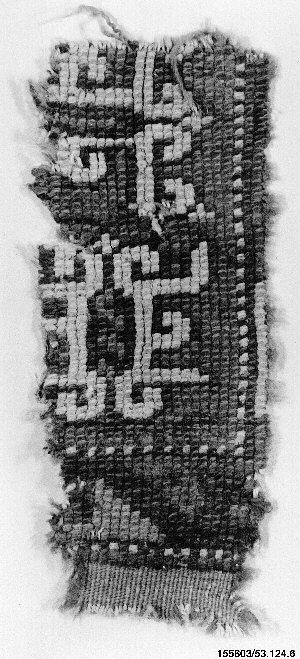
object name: carpet fragment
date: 1201-1400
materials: wool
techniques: asymmetrically knotted pile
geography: turkey